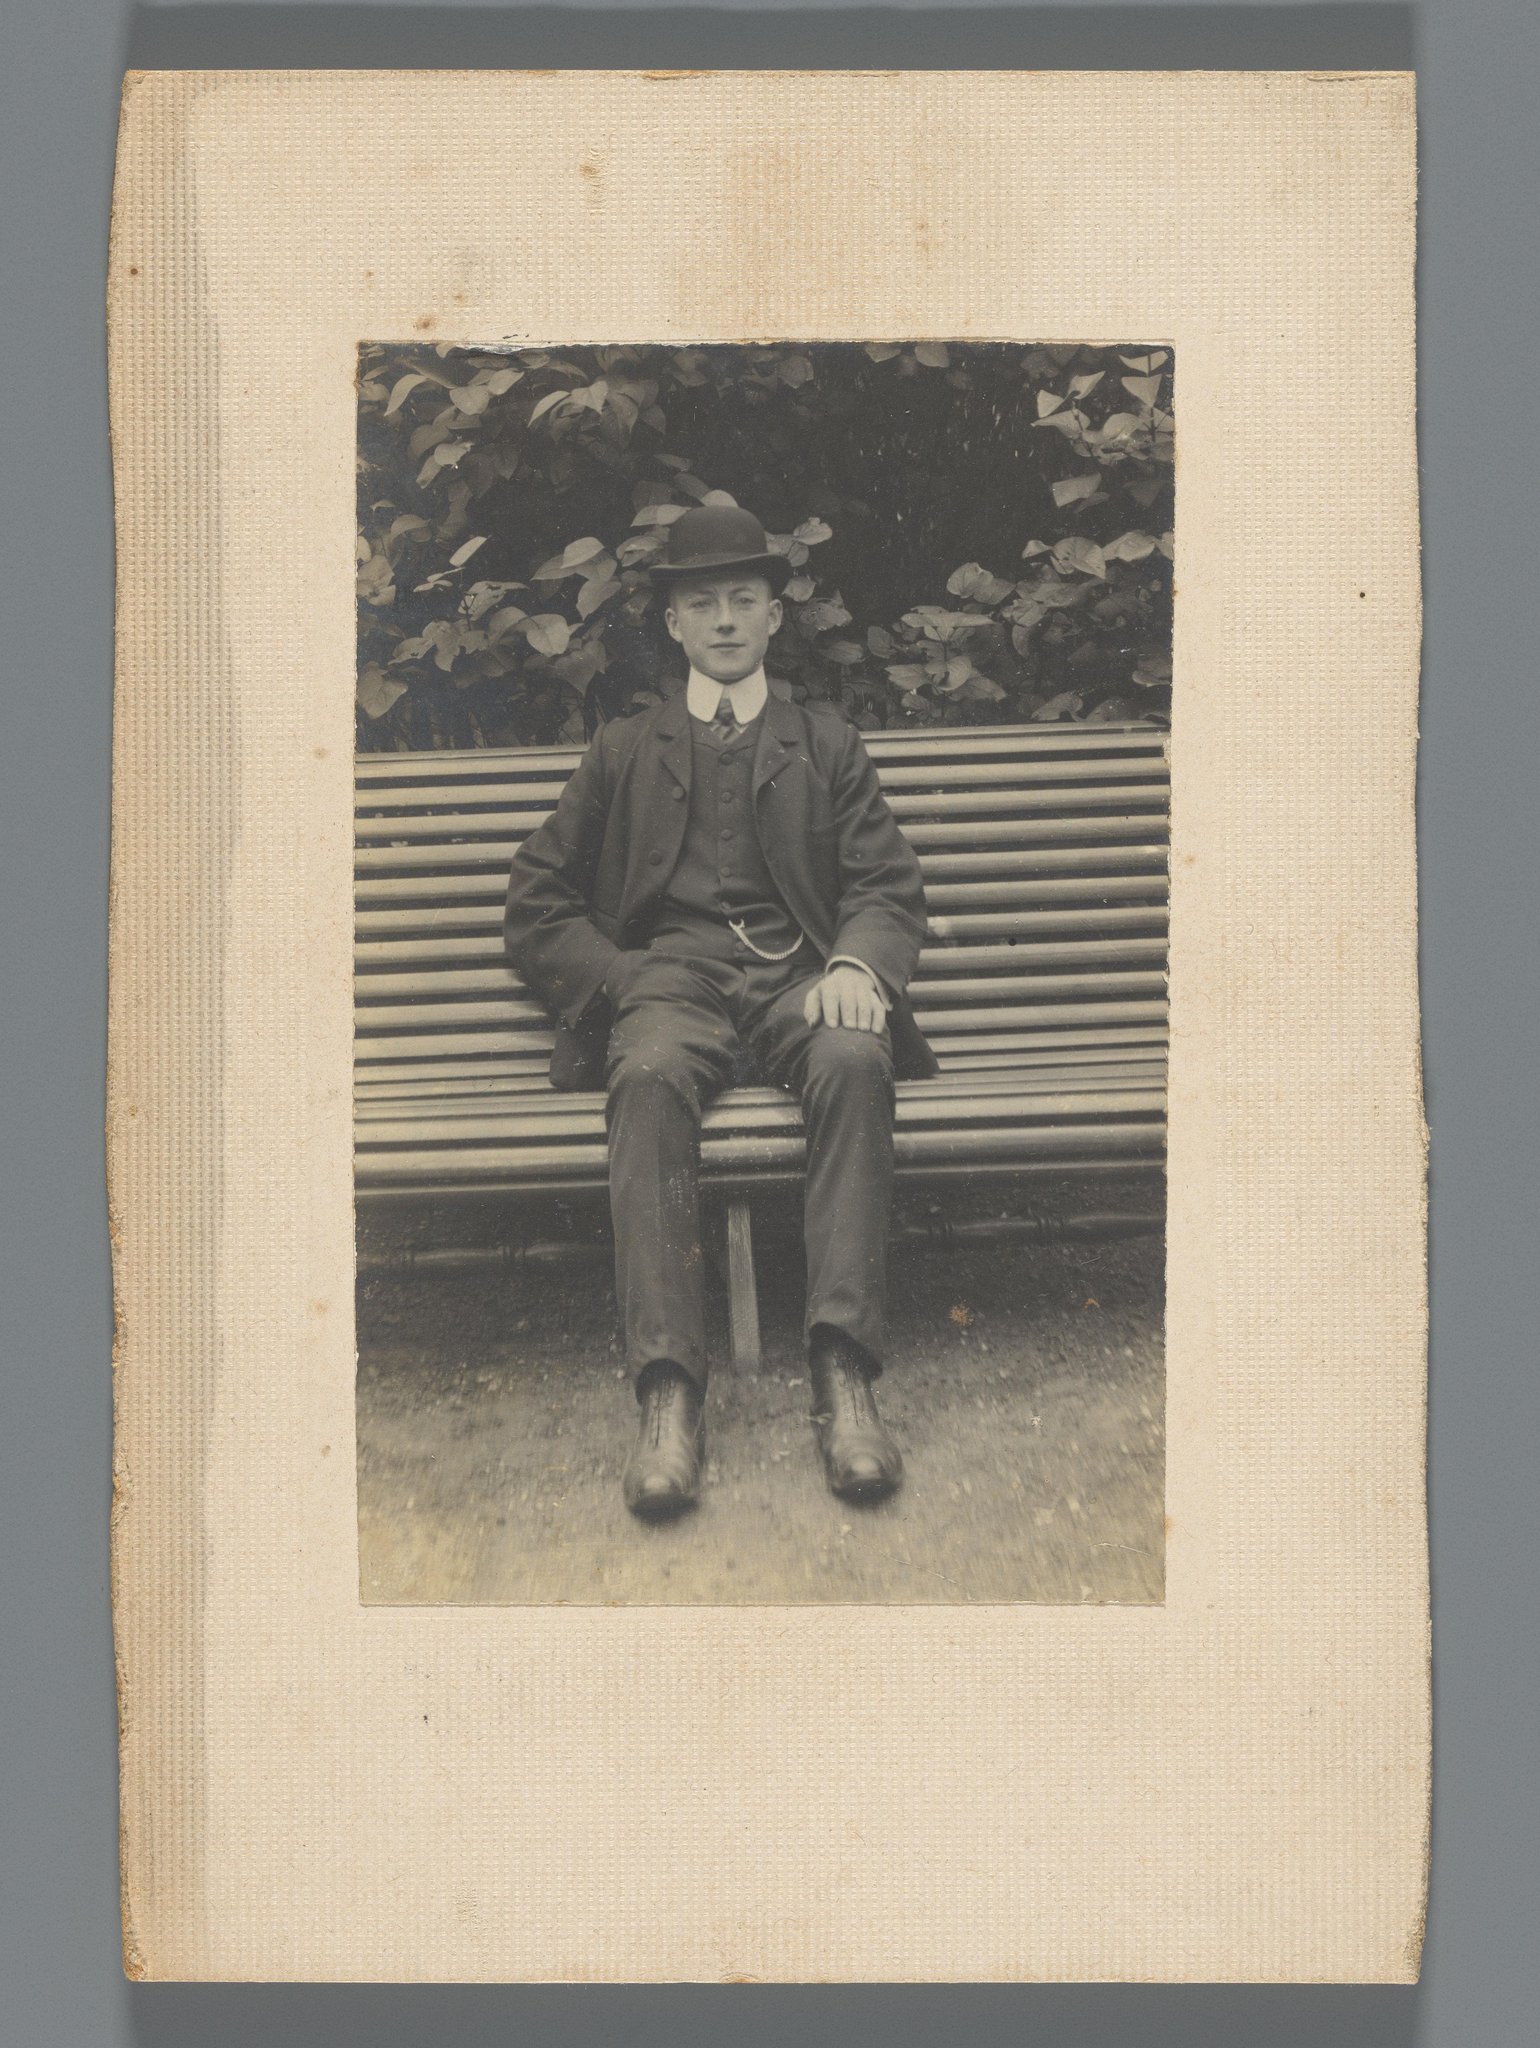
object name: cabinet photograph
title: Portret van een onbekende jongen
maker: Anonymous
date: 1885-1930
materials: paper, cardboard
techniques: gelatin silver print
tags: anonymous historical person portrayed